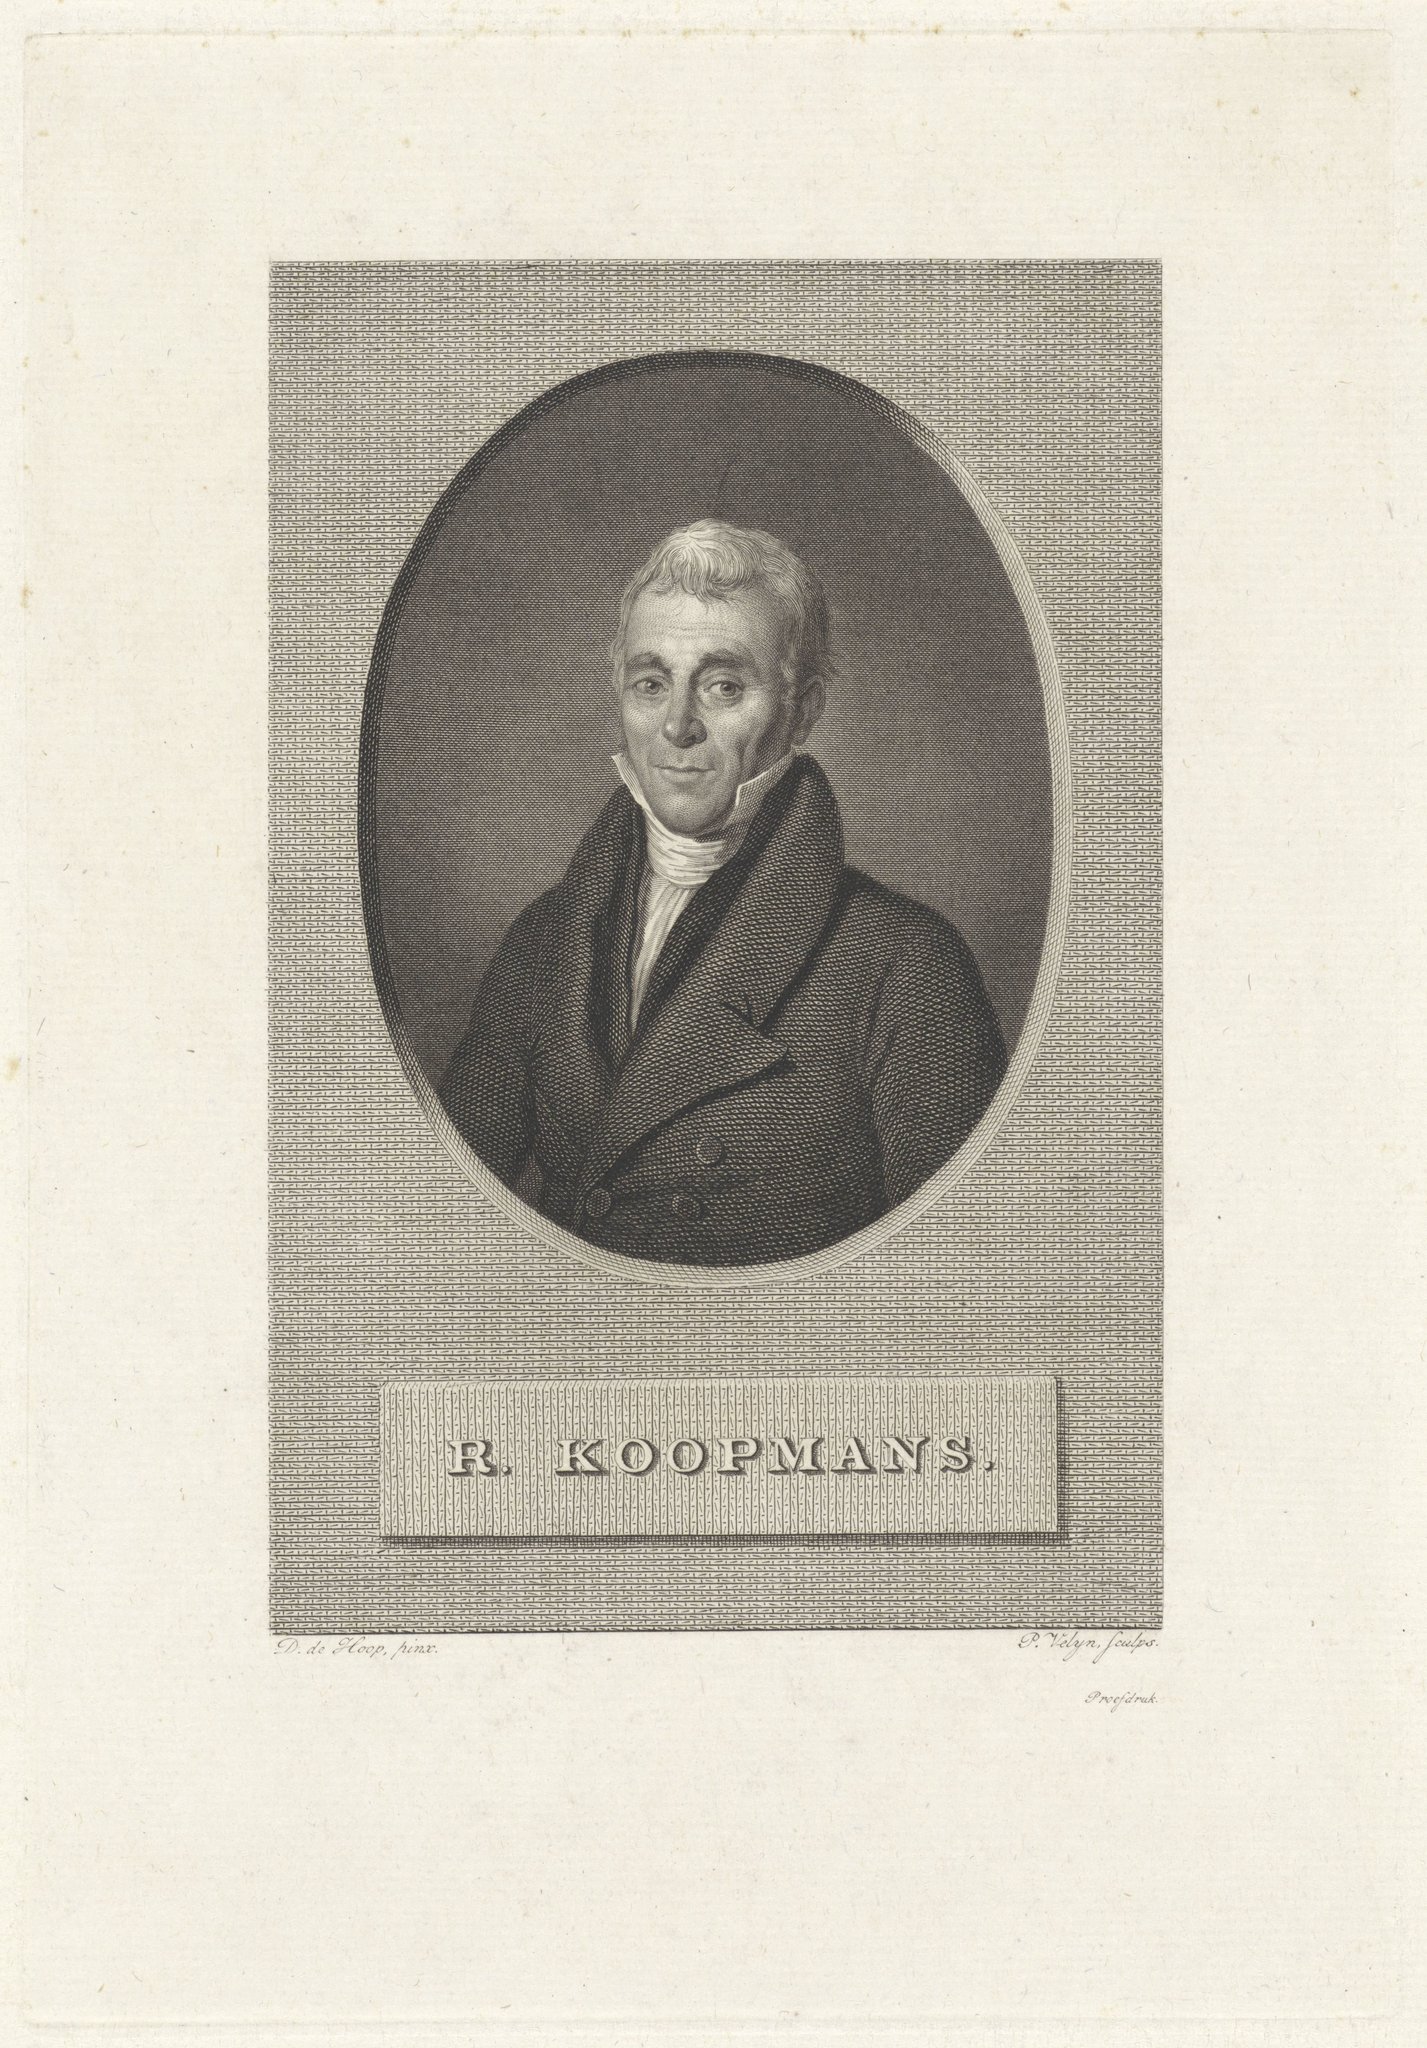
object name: print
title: Portret van Rinse Klaasses Koopmans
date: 1797-1836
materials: paper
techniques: engraving, etching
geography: netherlands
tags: koudum, predikant, rinse klaasses koopmans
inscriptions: collector's mark: Lugt 2228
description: Portret van Rinse Klaasses Koopmans, doopsgezinde predikant en theoloog te Amsterdam.